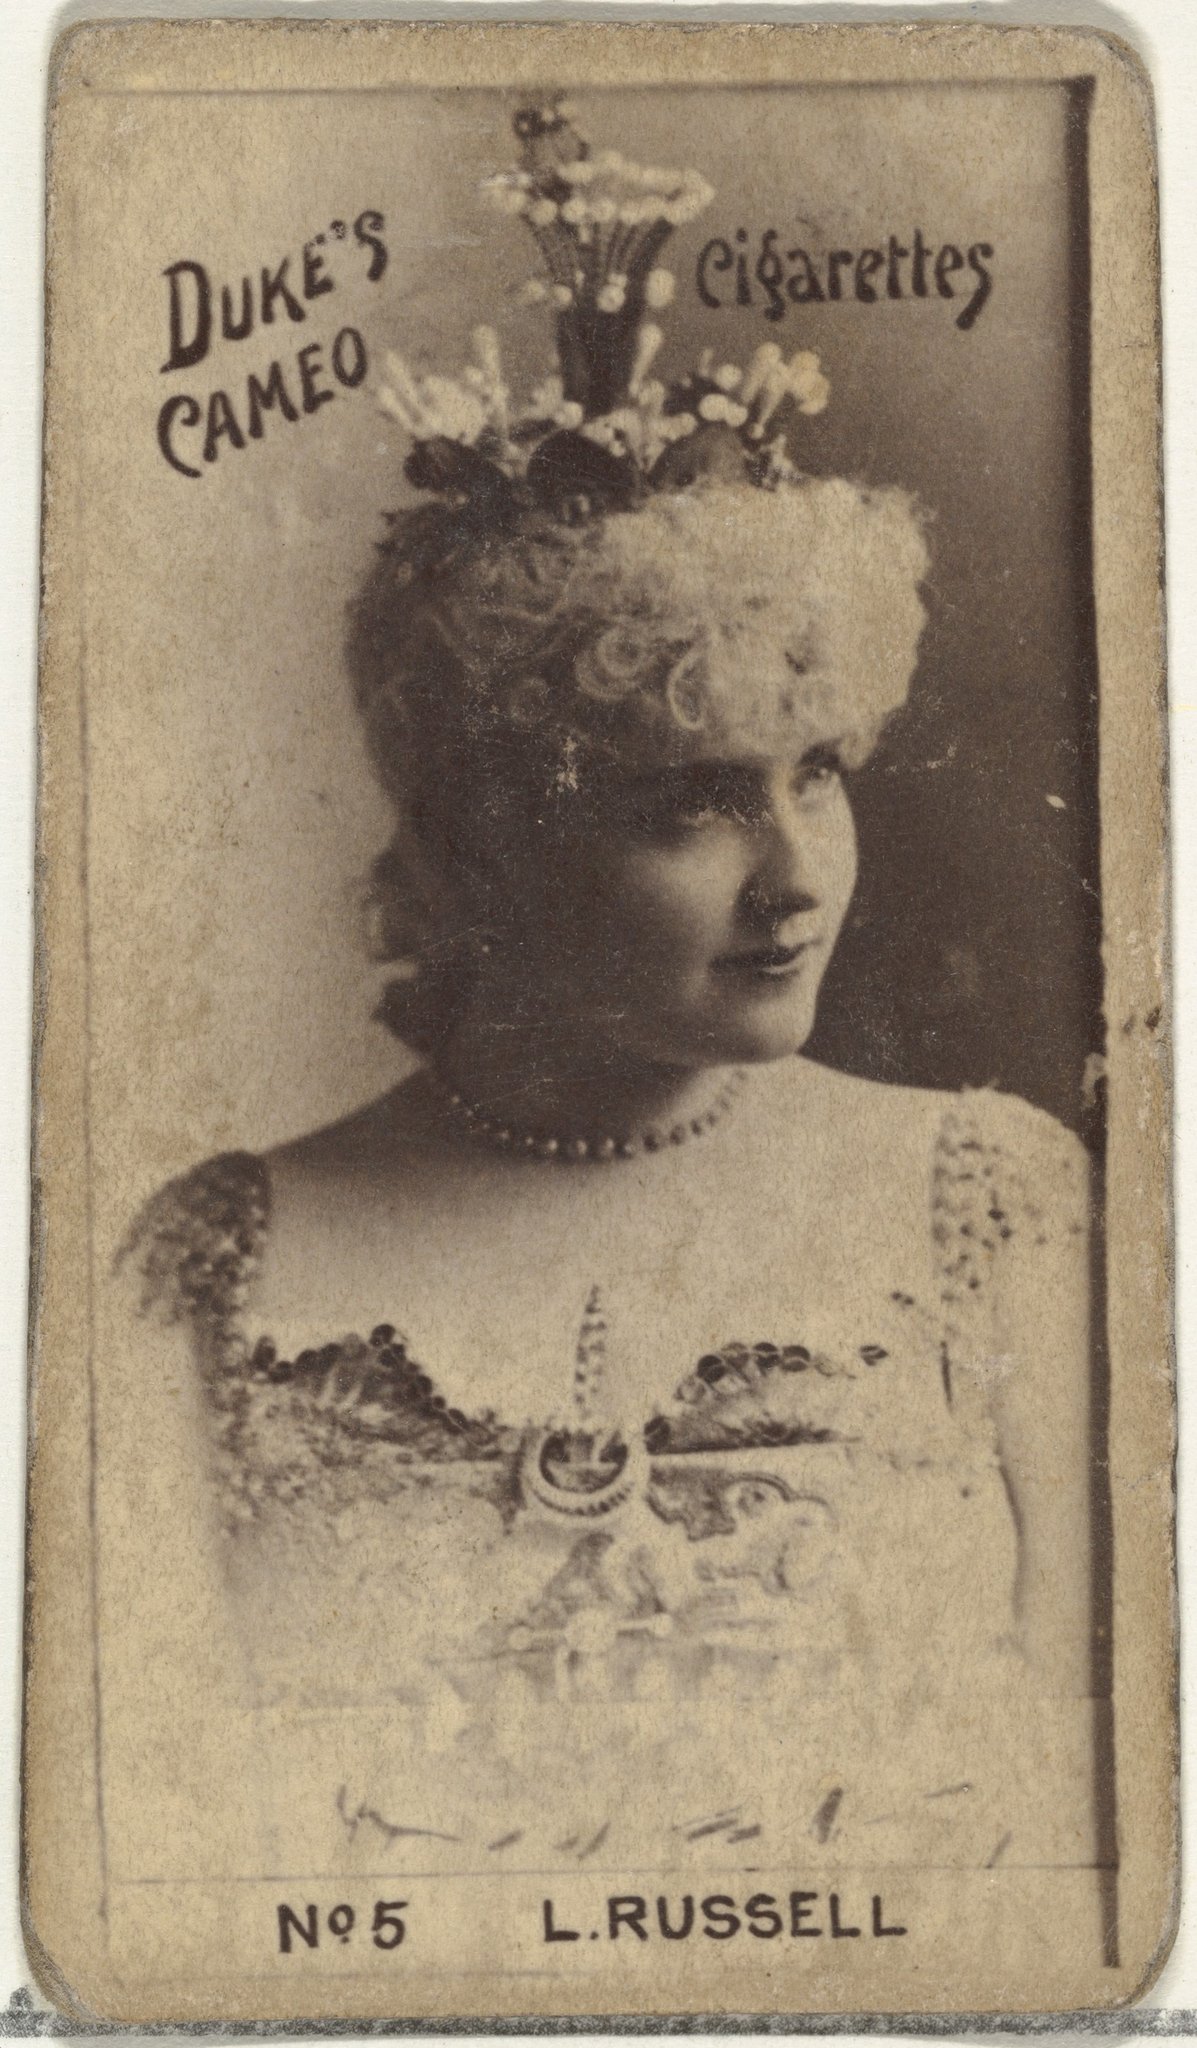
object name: photograph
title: Card Number 5, Lillian Russell, from the Actors and Actresses series (N145-4) issued by Duke Sons & Co. to promote Cameo Cigarettes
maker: w. duke, sons & co.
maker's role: publisher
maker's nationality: american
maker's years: 1870-1920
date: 1880-1889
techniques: albumen silver print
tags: portraits,women,actresses